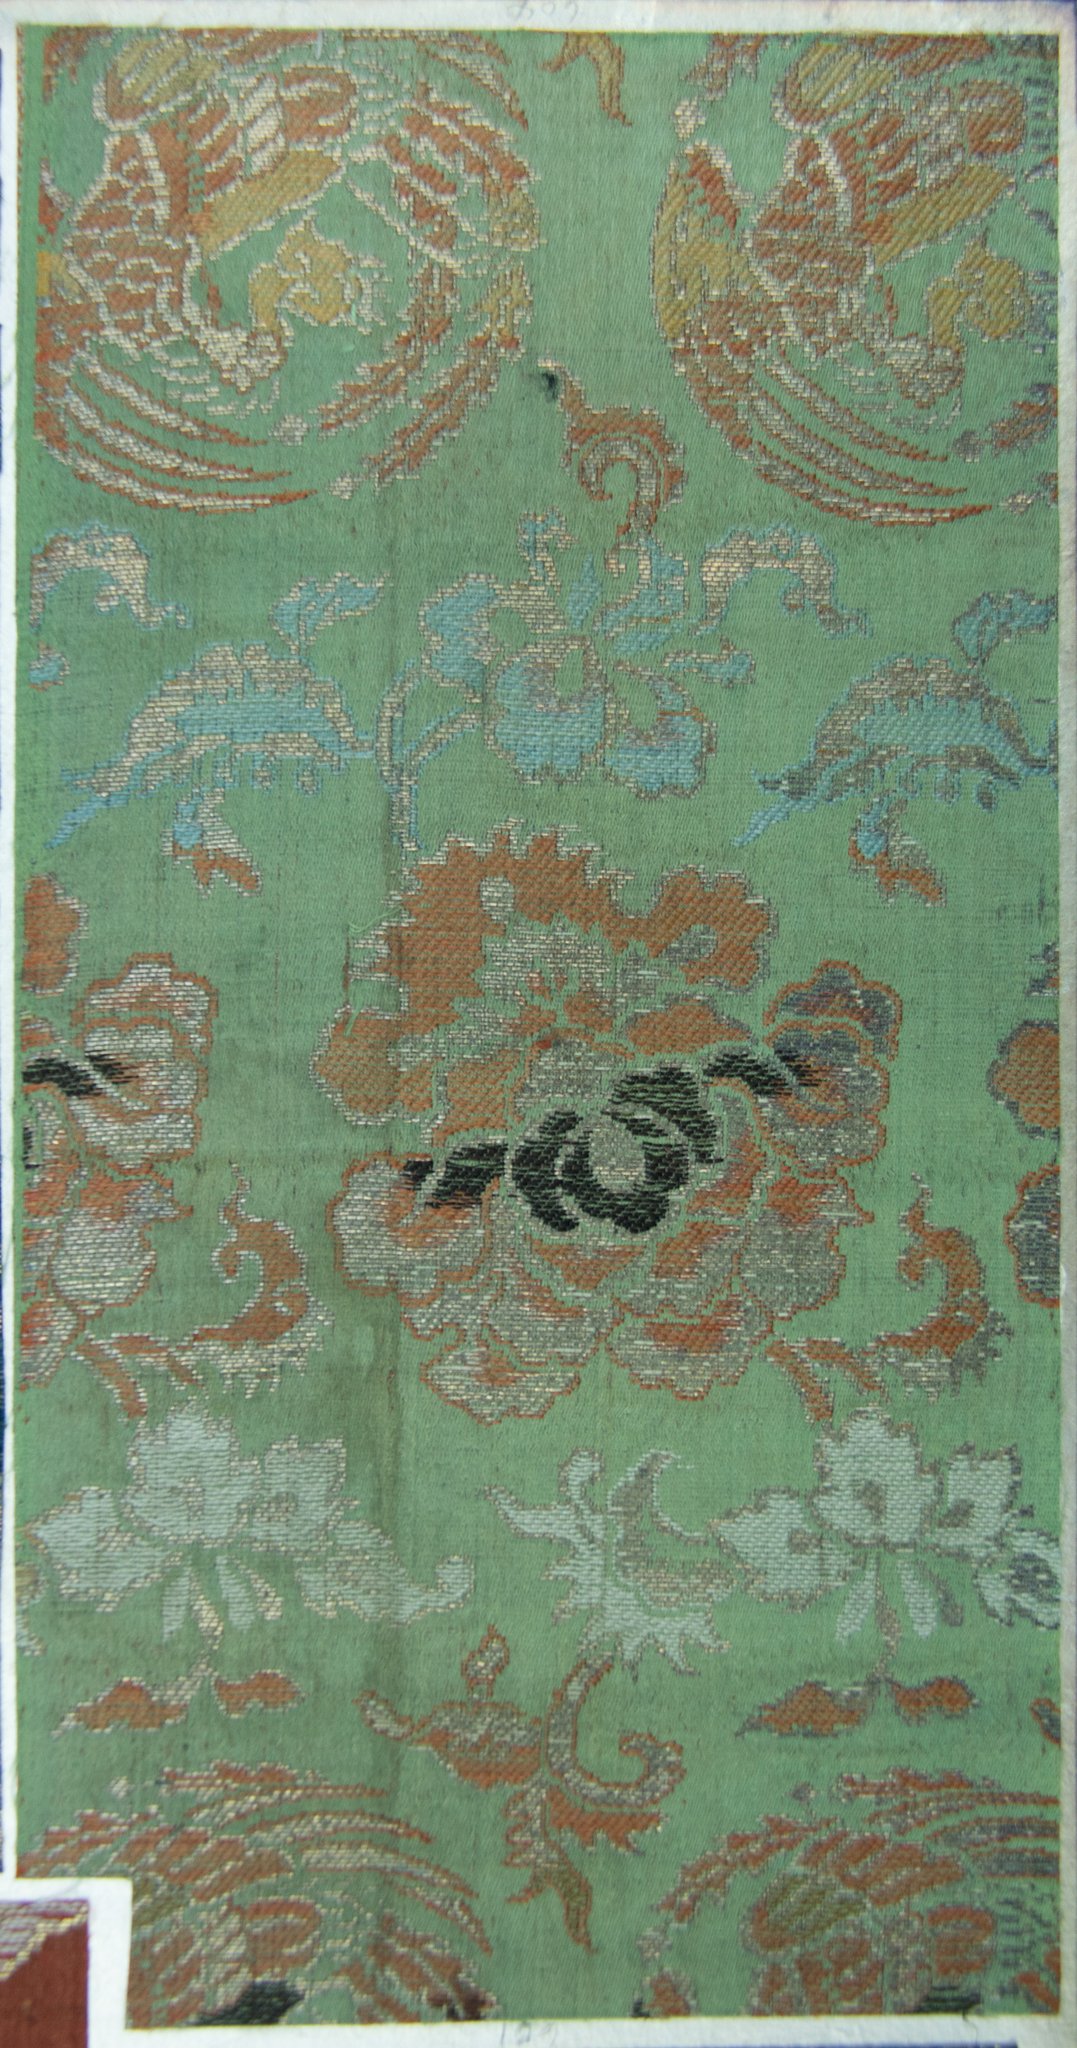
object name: piece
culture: japanese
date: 1601-1700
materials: silk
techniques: compound weave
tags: flowers